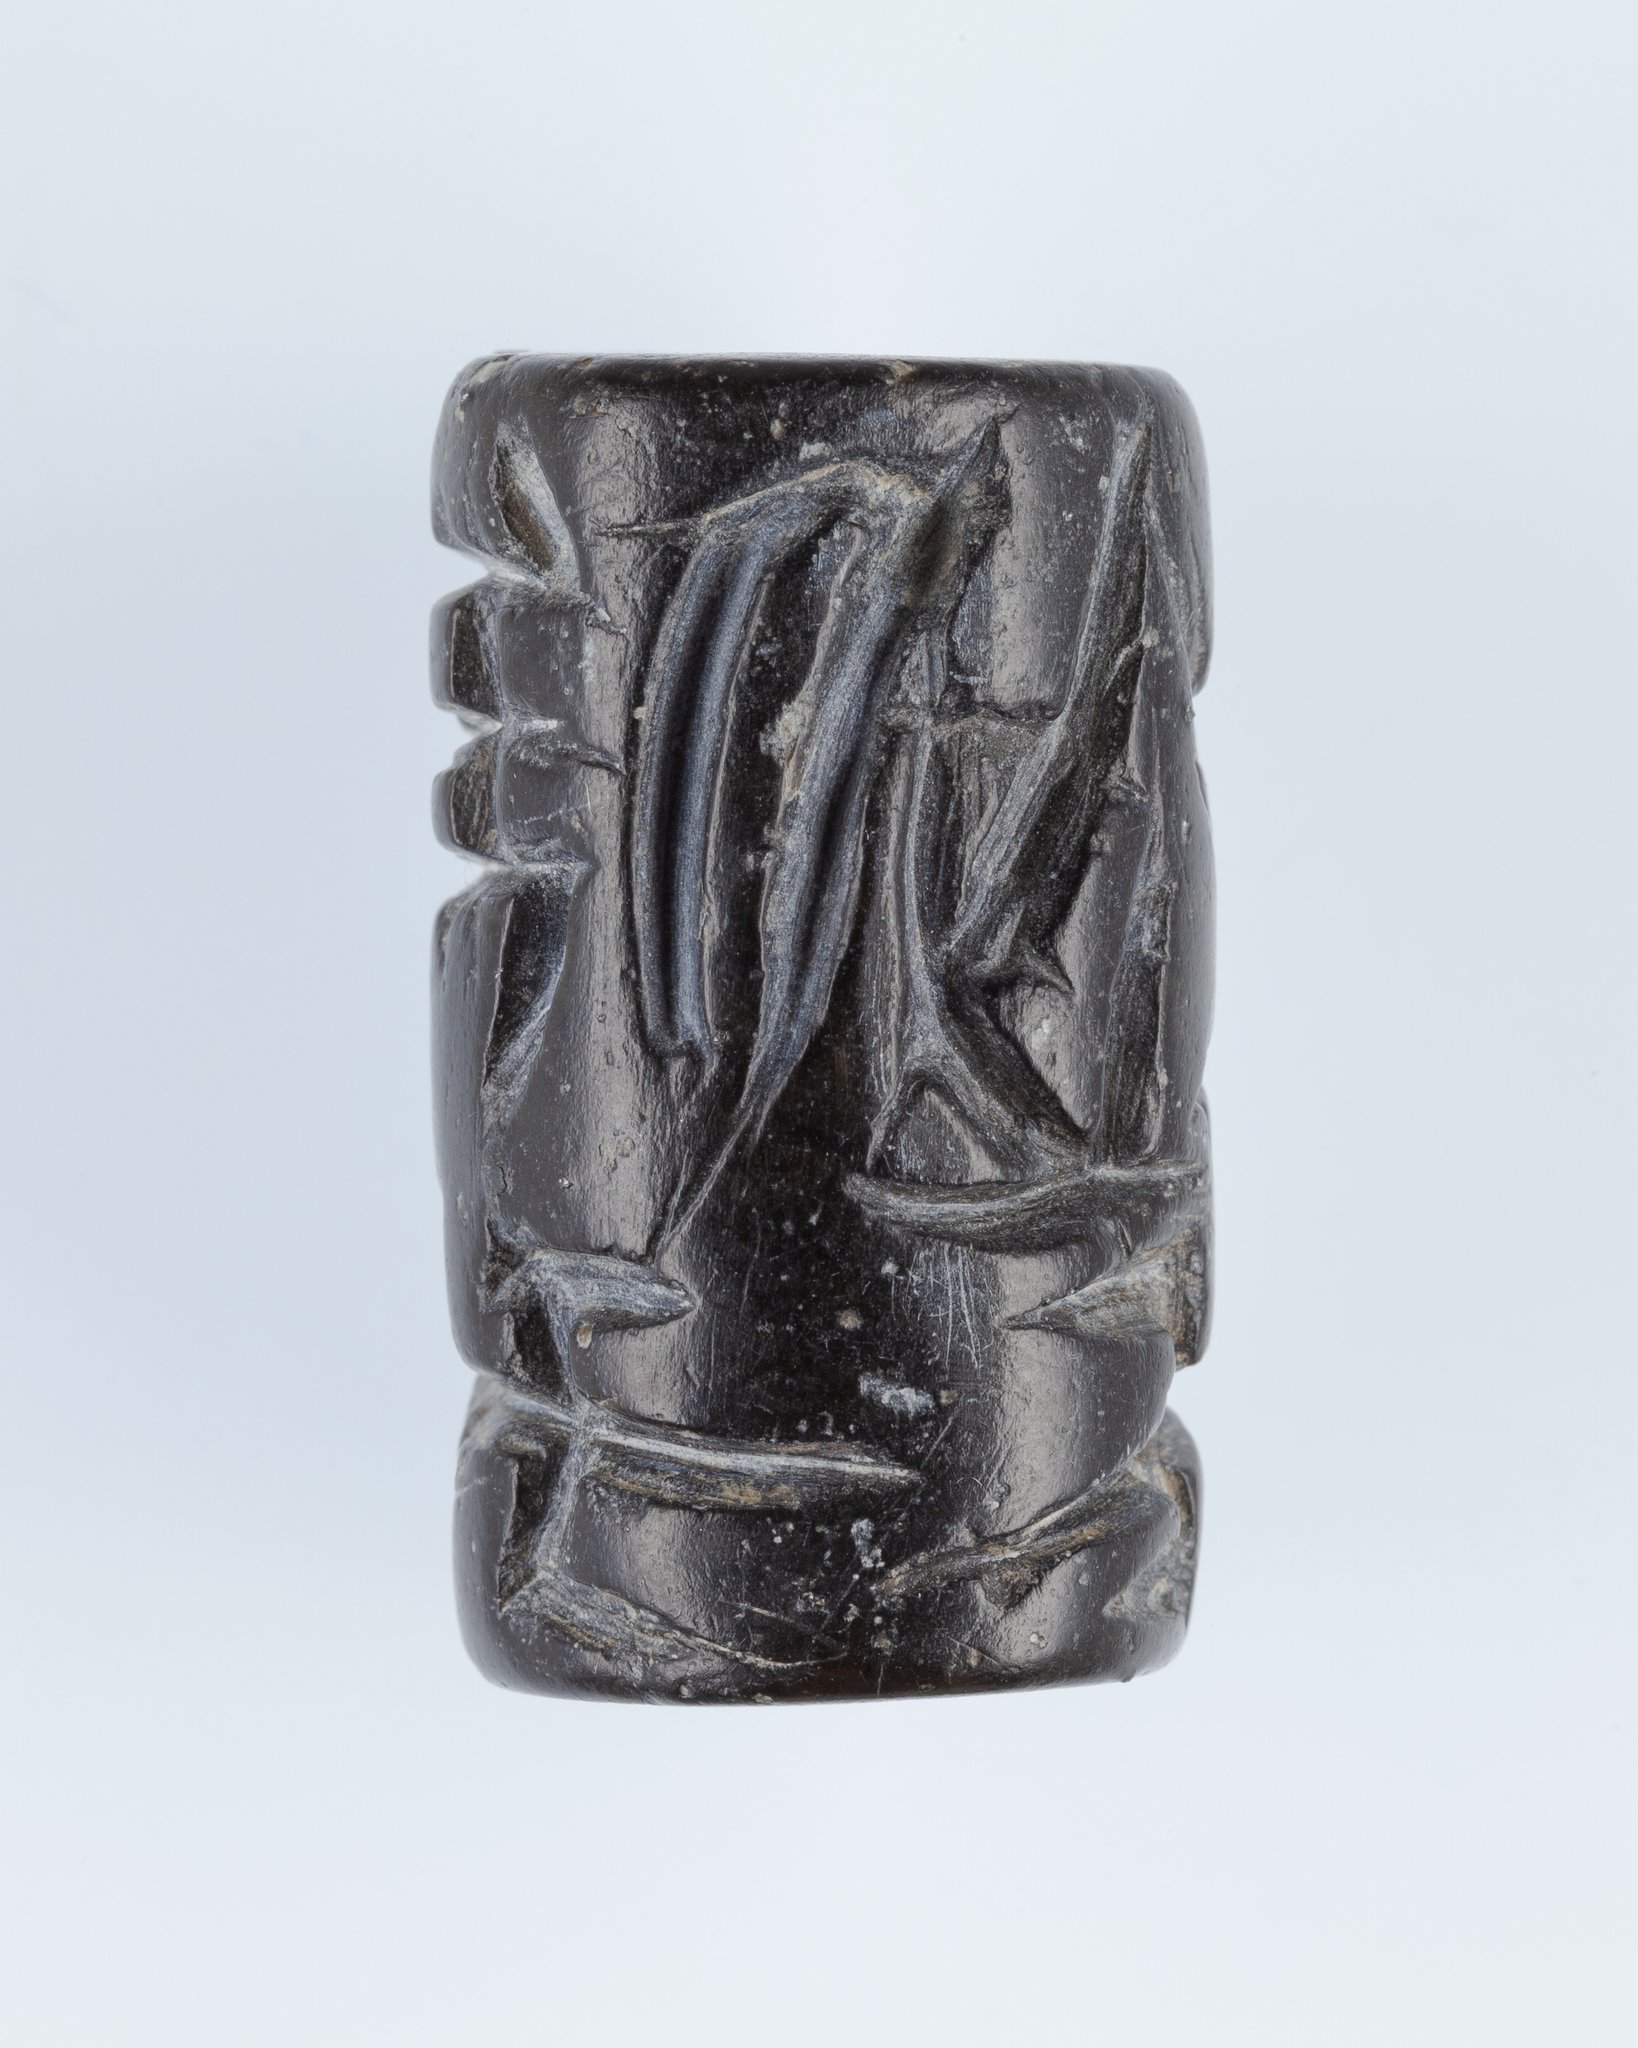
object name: cylinder seal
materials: stone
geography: egypt